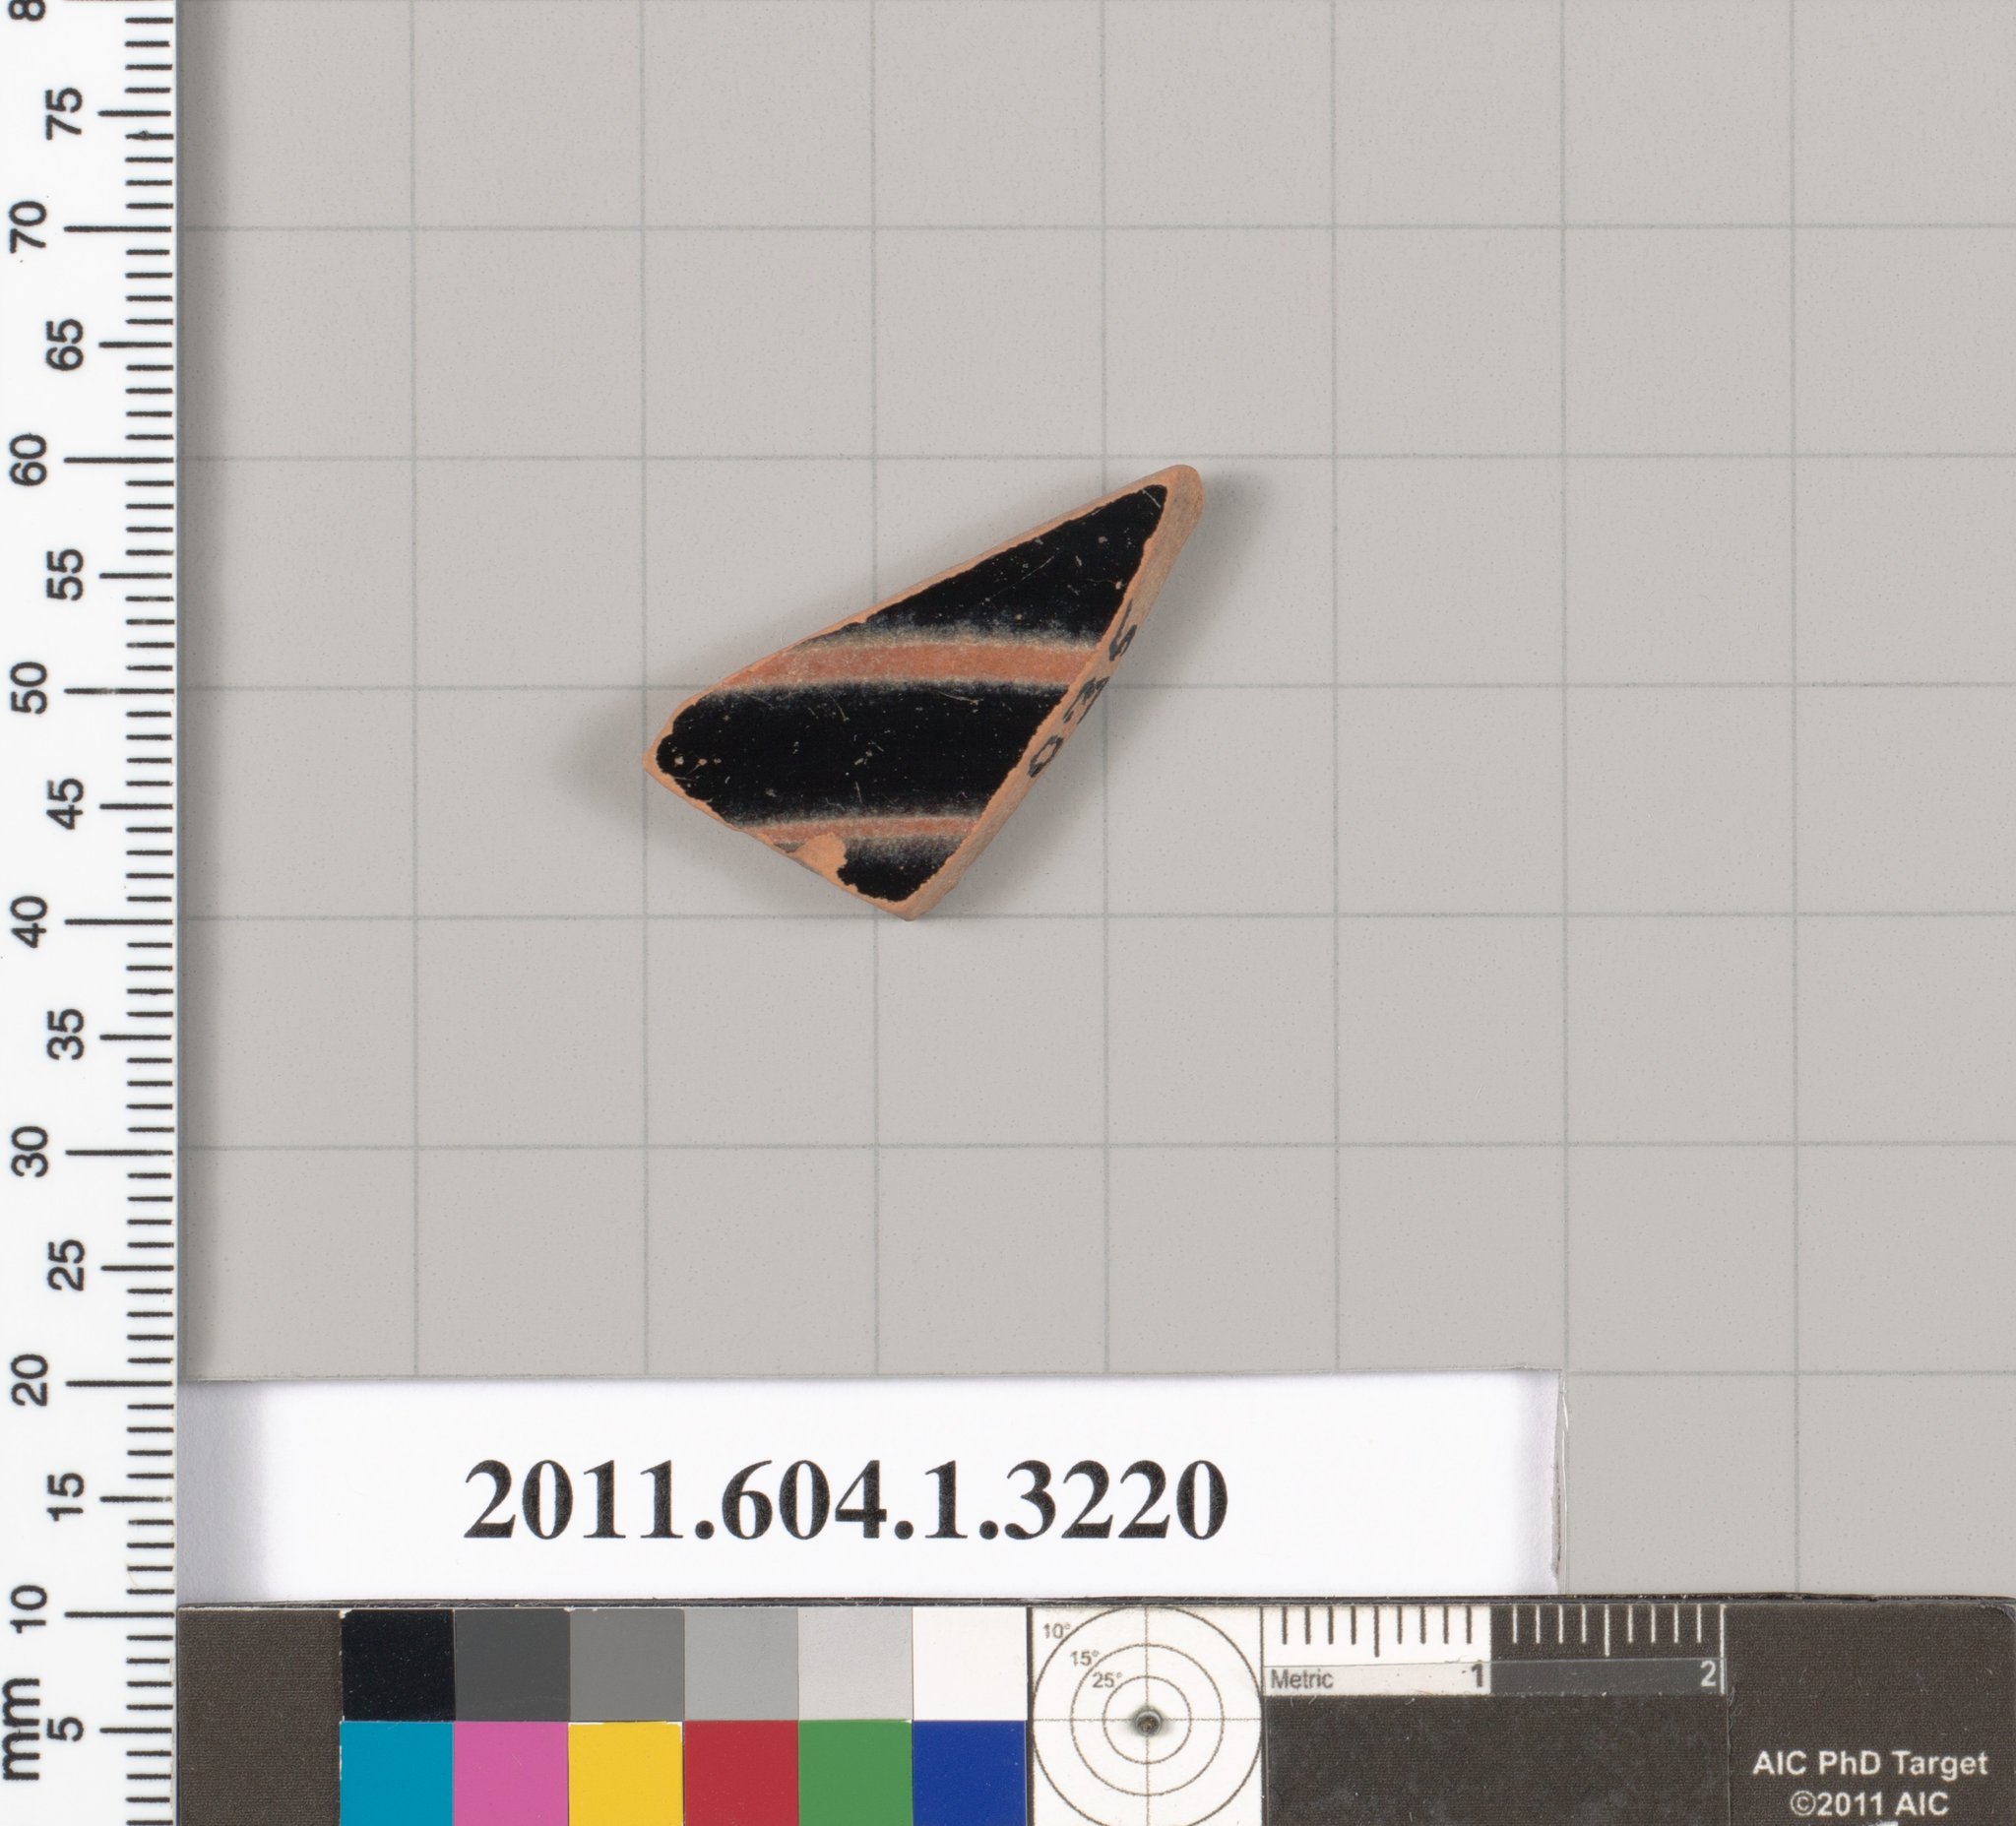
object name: kylix fragment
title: Terracotta fragment of a kylix (drinking cup)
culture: greek, attic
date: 600-401 BCE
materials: terracotta